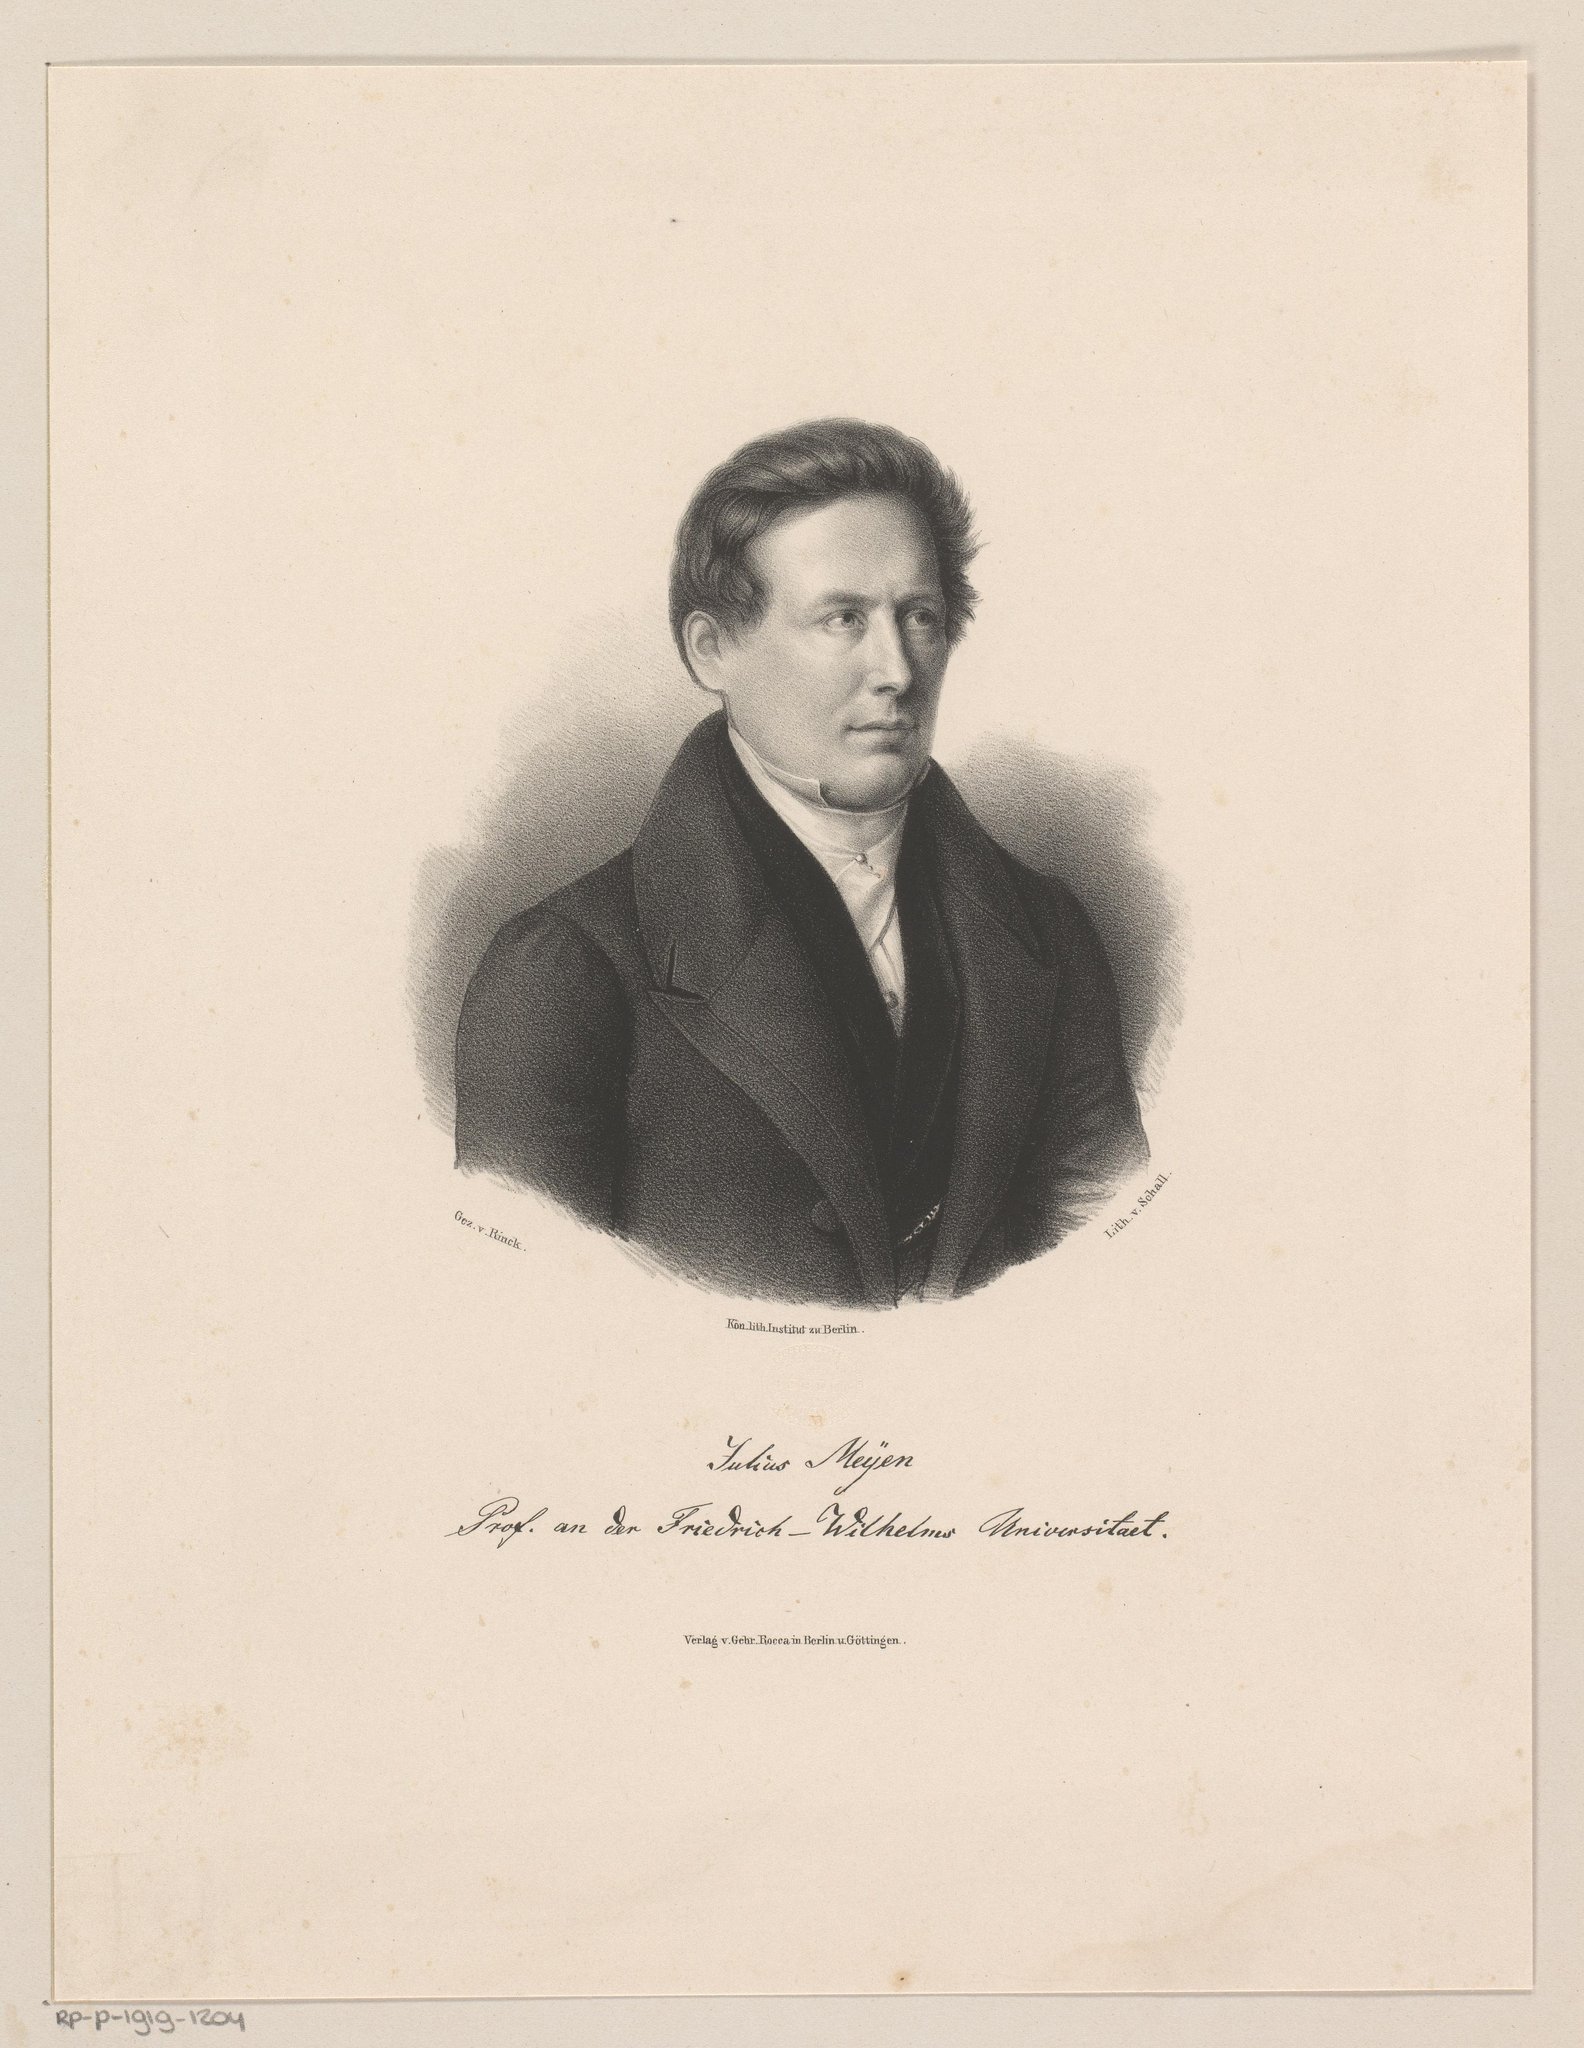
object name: print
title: Julius Meijen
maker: j.c. schall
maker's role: print maker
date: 1830-1860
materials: paper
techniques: lithograph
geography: berlin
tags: adult man, historical persons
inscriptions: collector's mark: Lugt 2228, check stamp: Lugt 5514